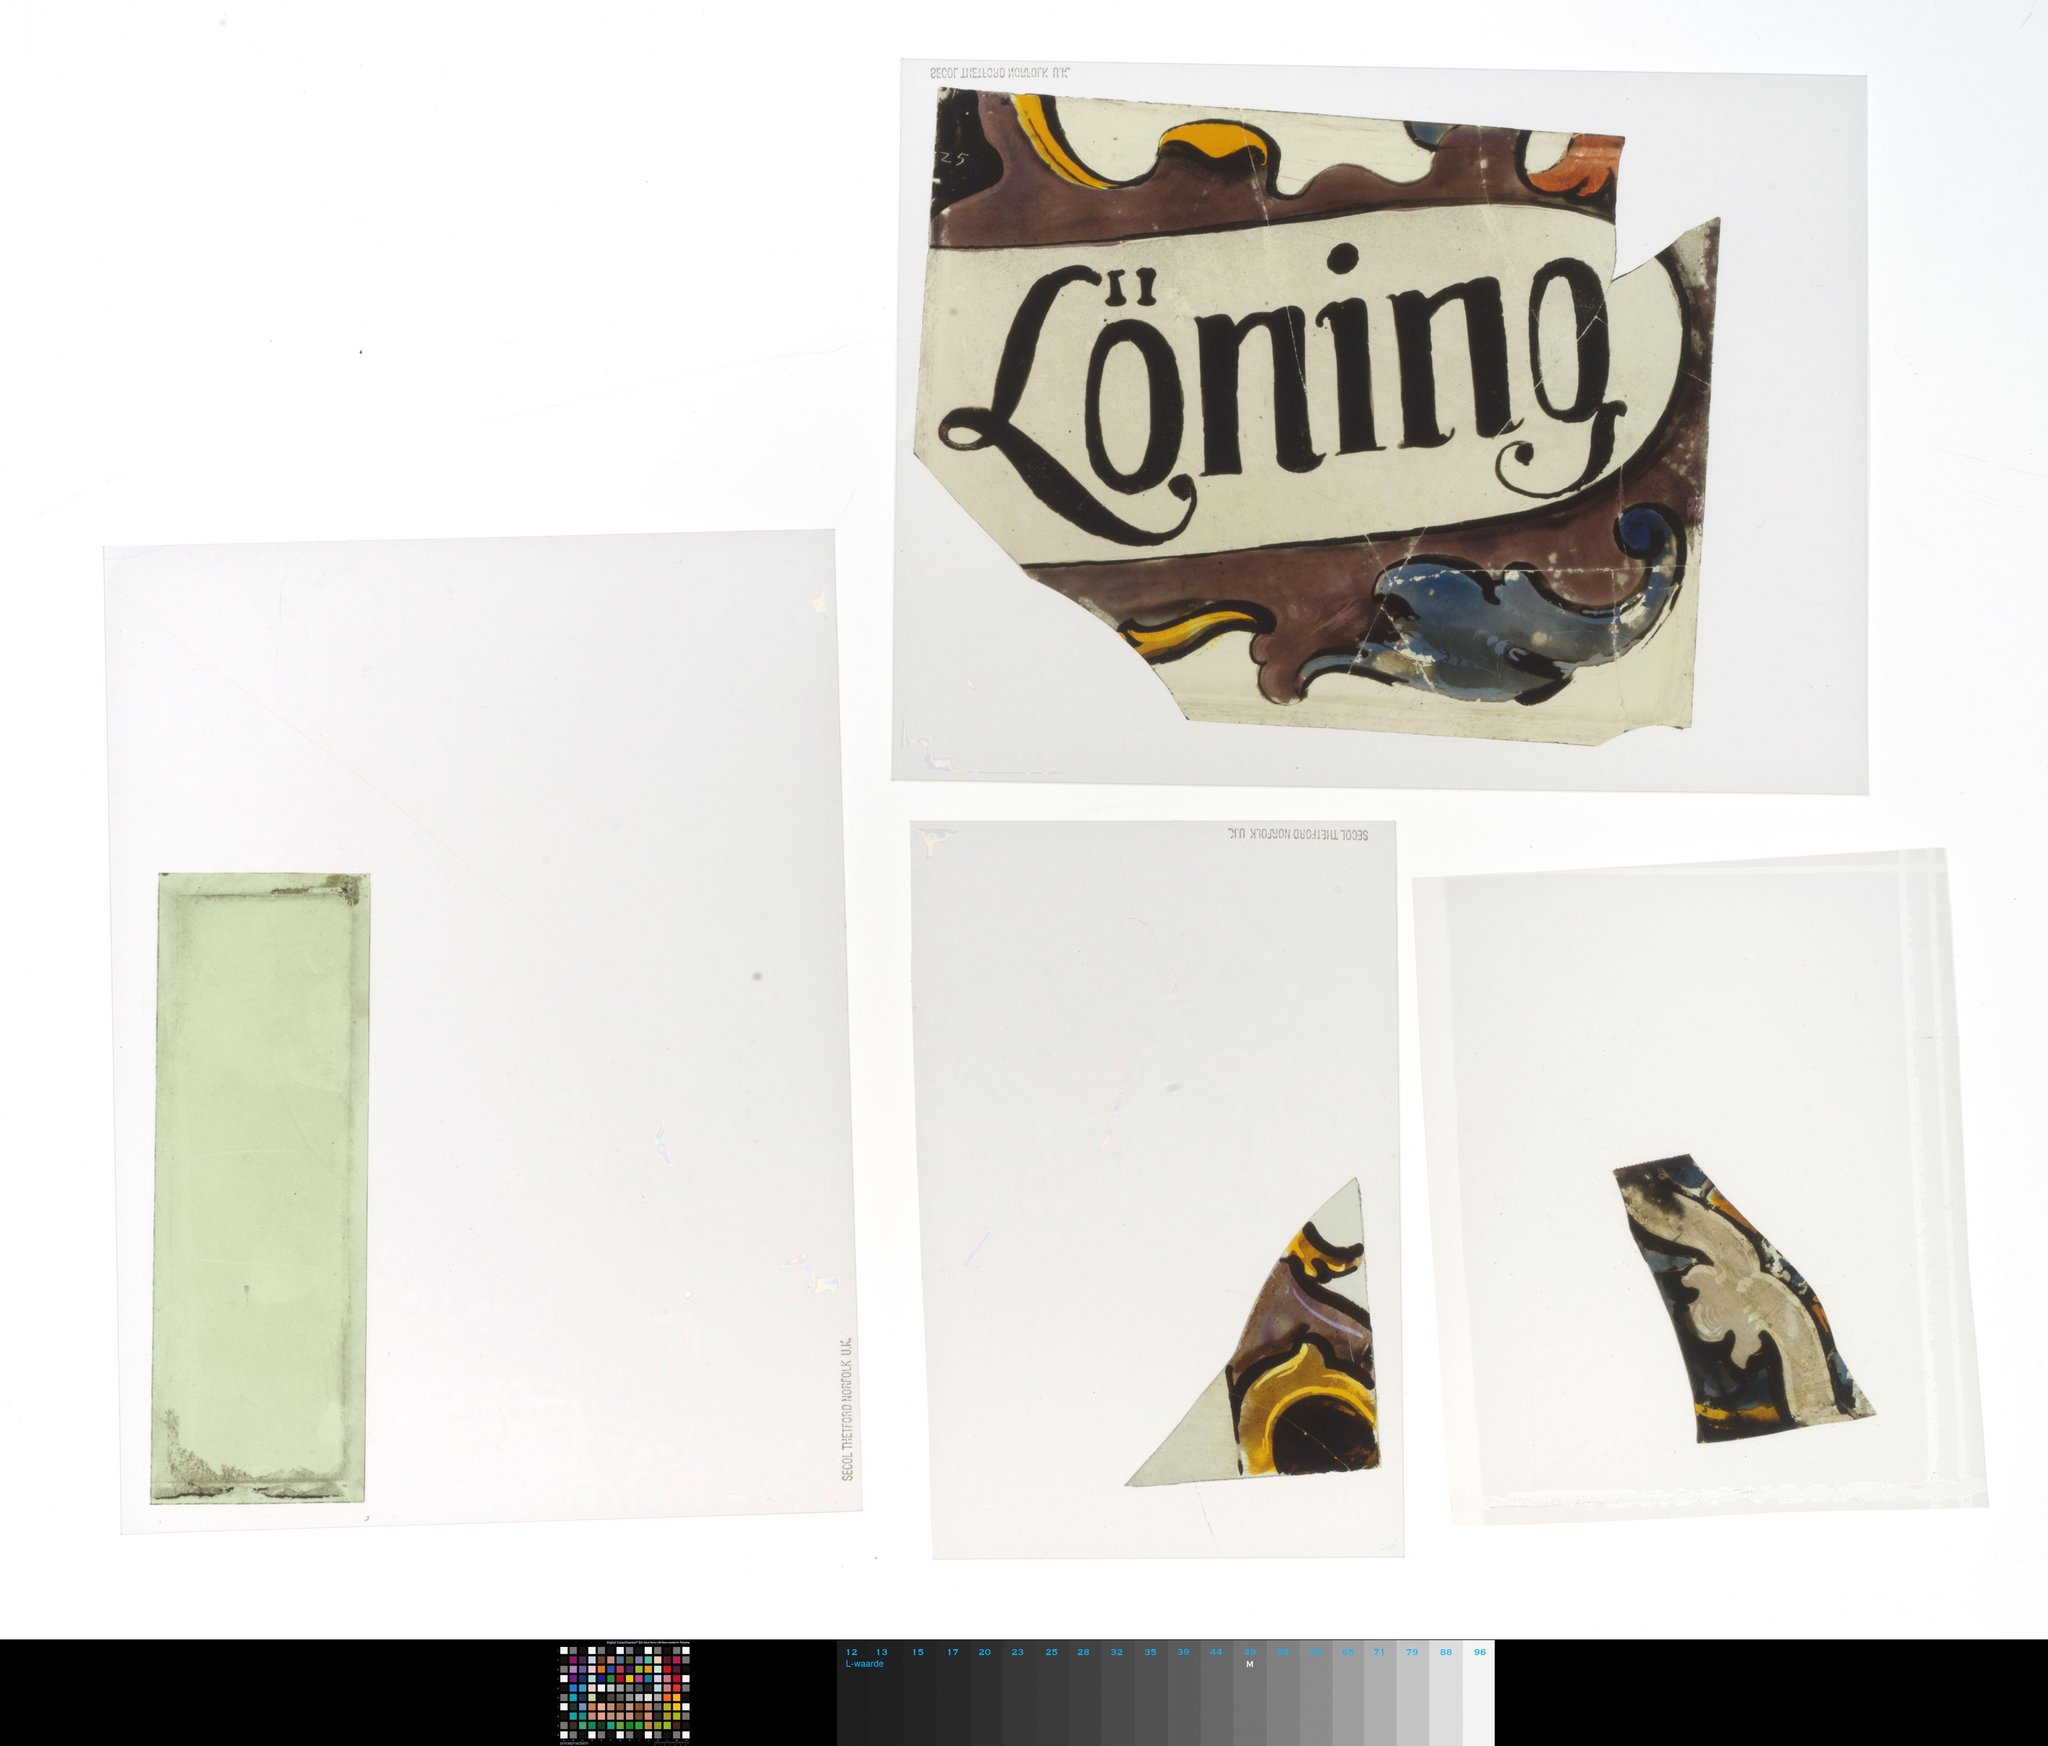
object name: light window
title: Fragmenten van gebrandschilderde ruit met vijf wapens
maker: Anonymous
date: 1600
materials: glass, lead, pigment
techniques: leading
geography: germany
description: Ruit van gebrandschilderd glas waarin vijf verschillende wapens: drie boven en twee onder. Onder de twee onderste wapens de onderschriften: "Henricus Loning" en "Henriette Weizel".